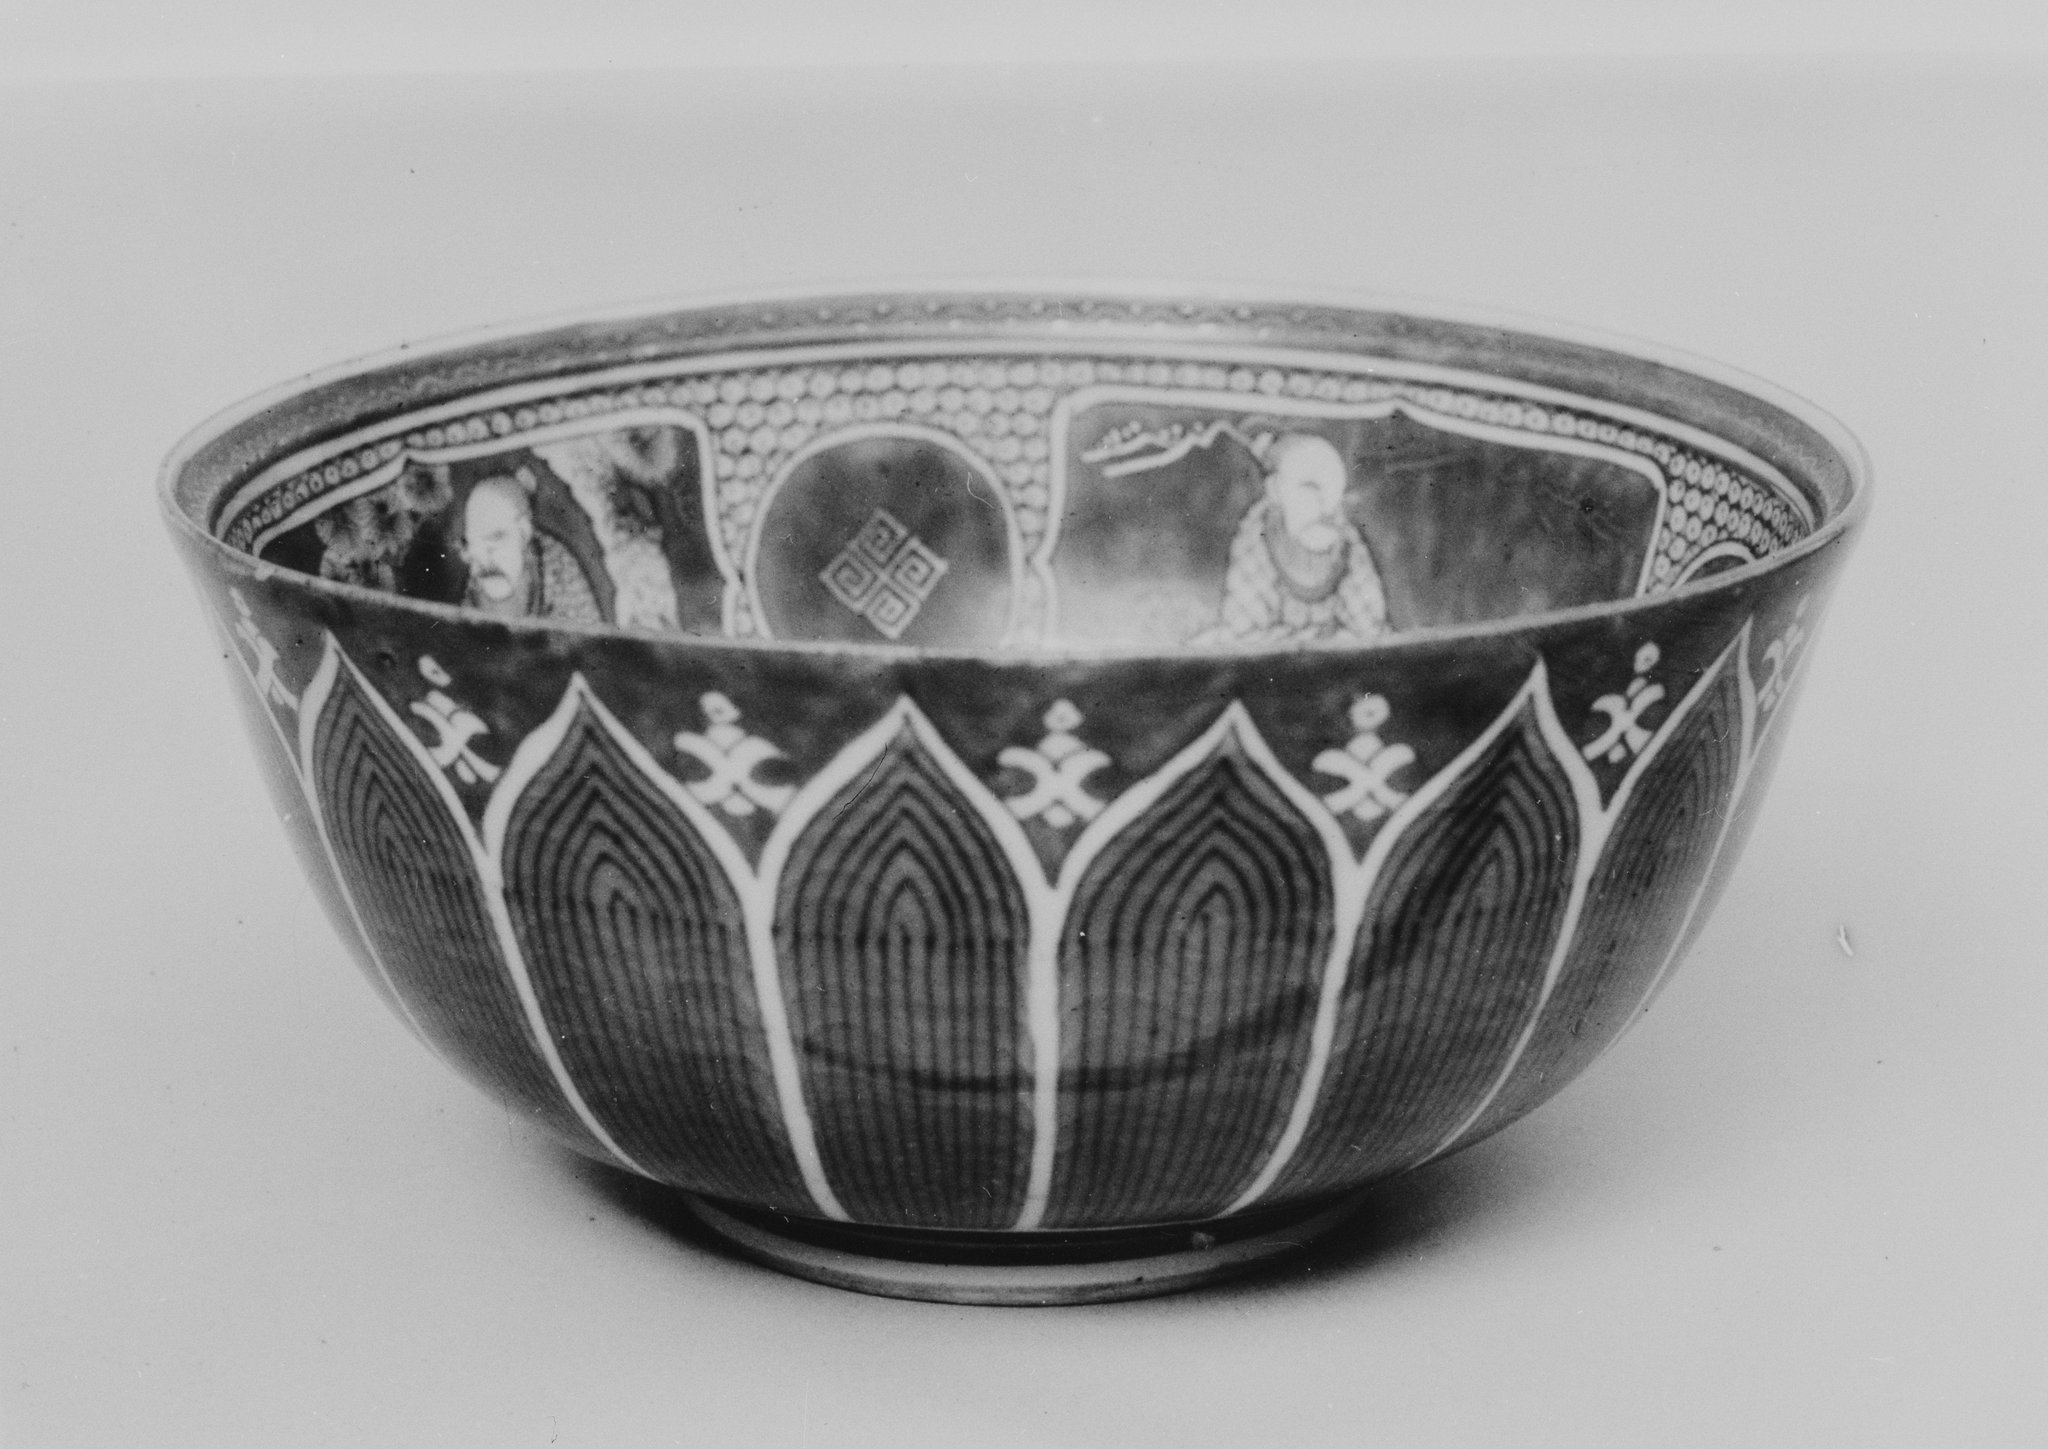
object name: bowl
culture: japanese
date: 1850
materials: enamel, glaze, porcelain